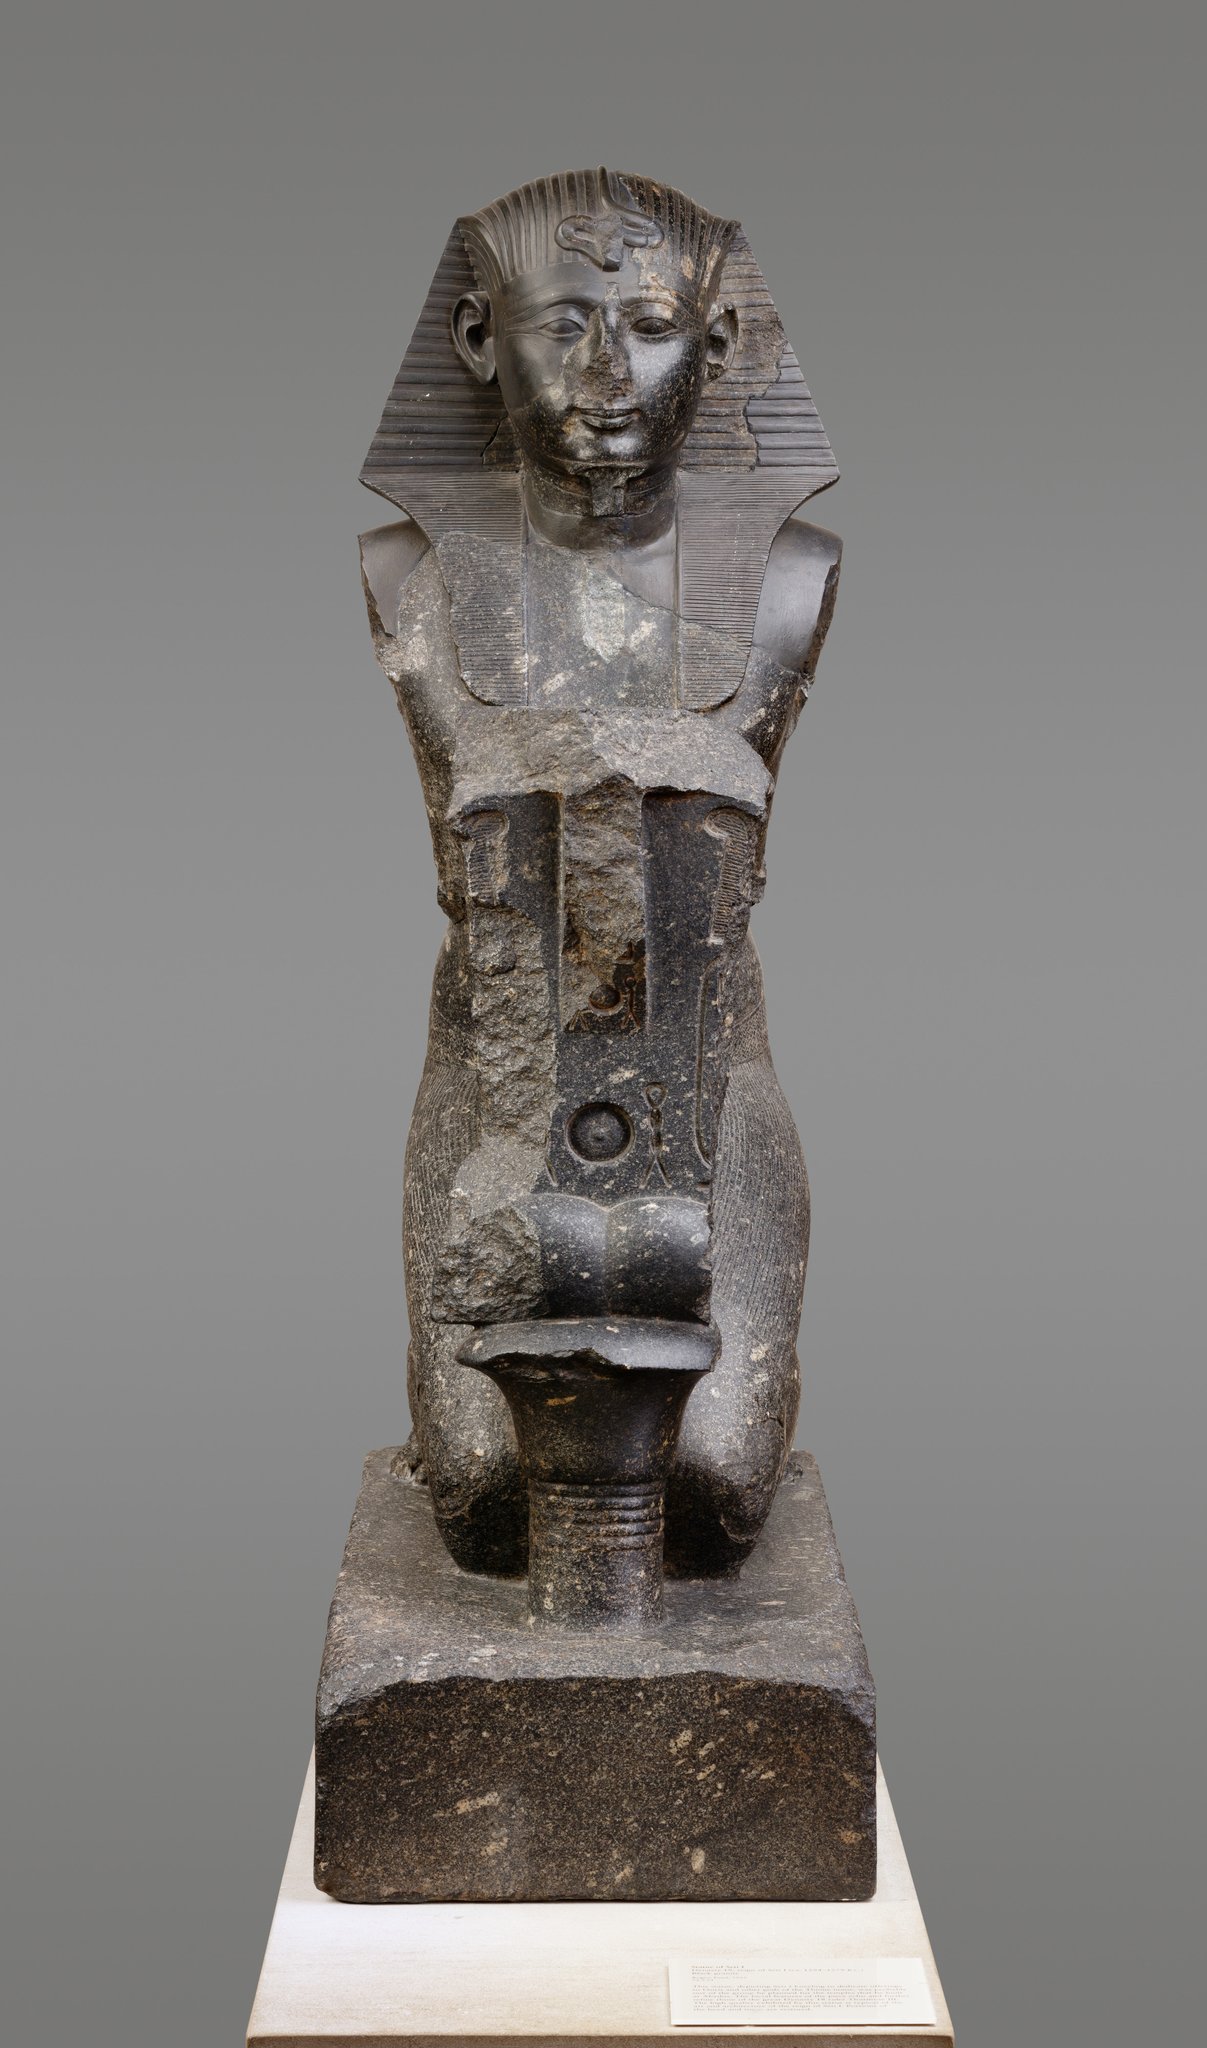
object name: statue, kneeling king, seti i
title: Statue of Seti I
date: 1294-1279 BCE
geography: northern upper egypt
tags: kings